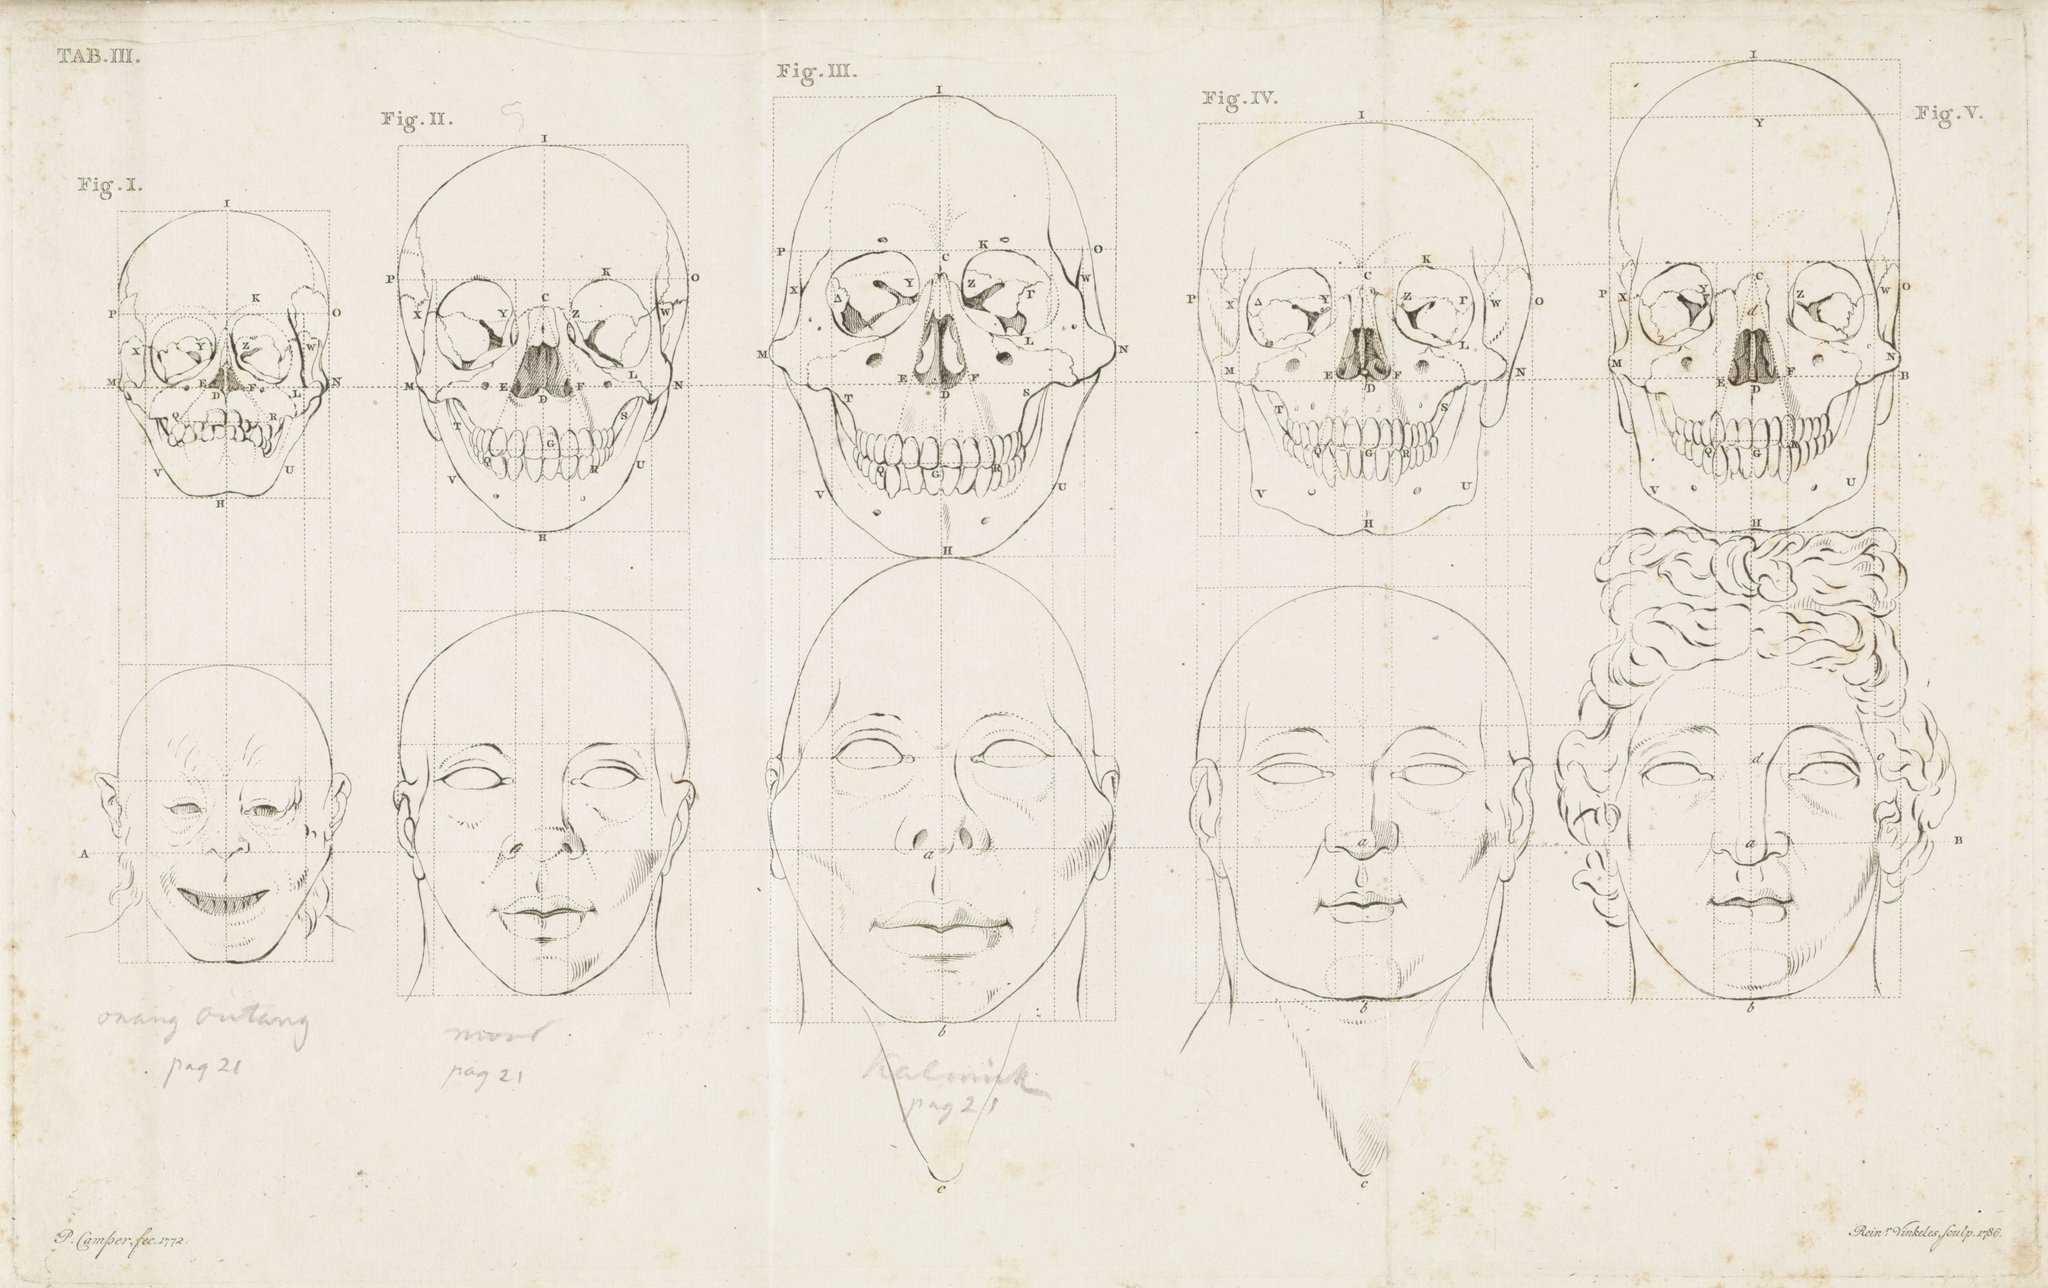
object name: print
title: Studie van een apenkop en een menselijke kop en schedel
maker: reinier vinkeles (i)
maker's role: draughtsman, print maker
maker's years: 1741-1816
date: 1786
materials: paper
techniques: etching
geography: amsterdam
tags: head (human) (+ sideview, profile)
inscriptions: collector's mark: Lugt 2228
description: Blad met vier studies van een menselijke kop, een van een aap, en van de bijbehorende schedels.